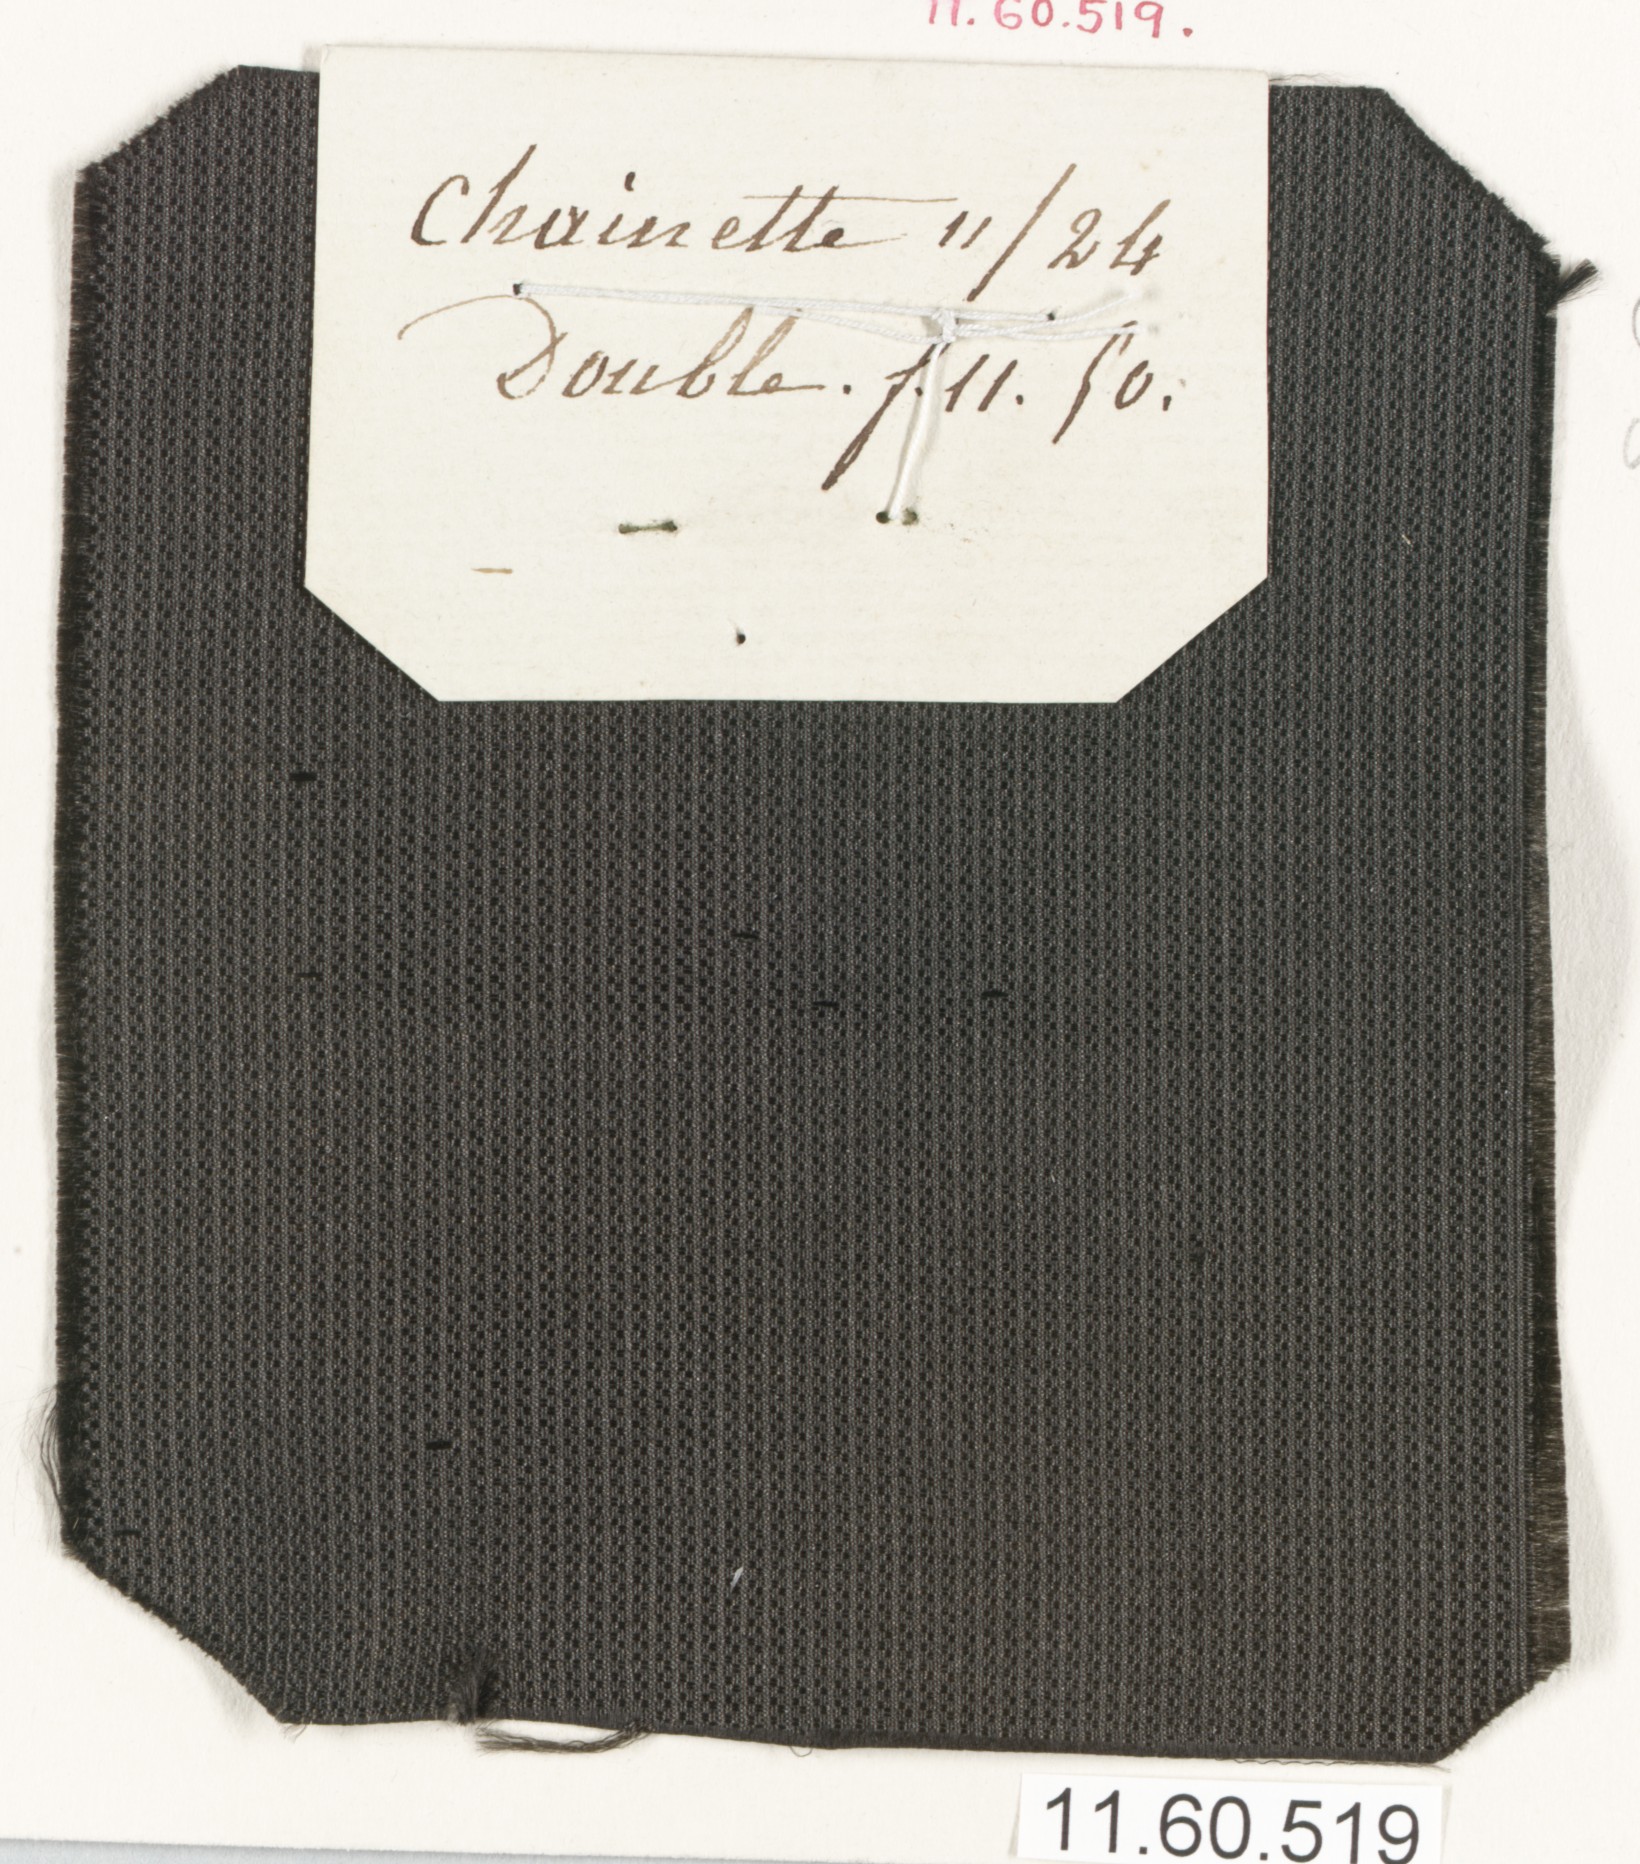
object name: sample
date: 1825-1850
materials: silk